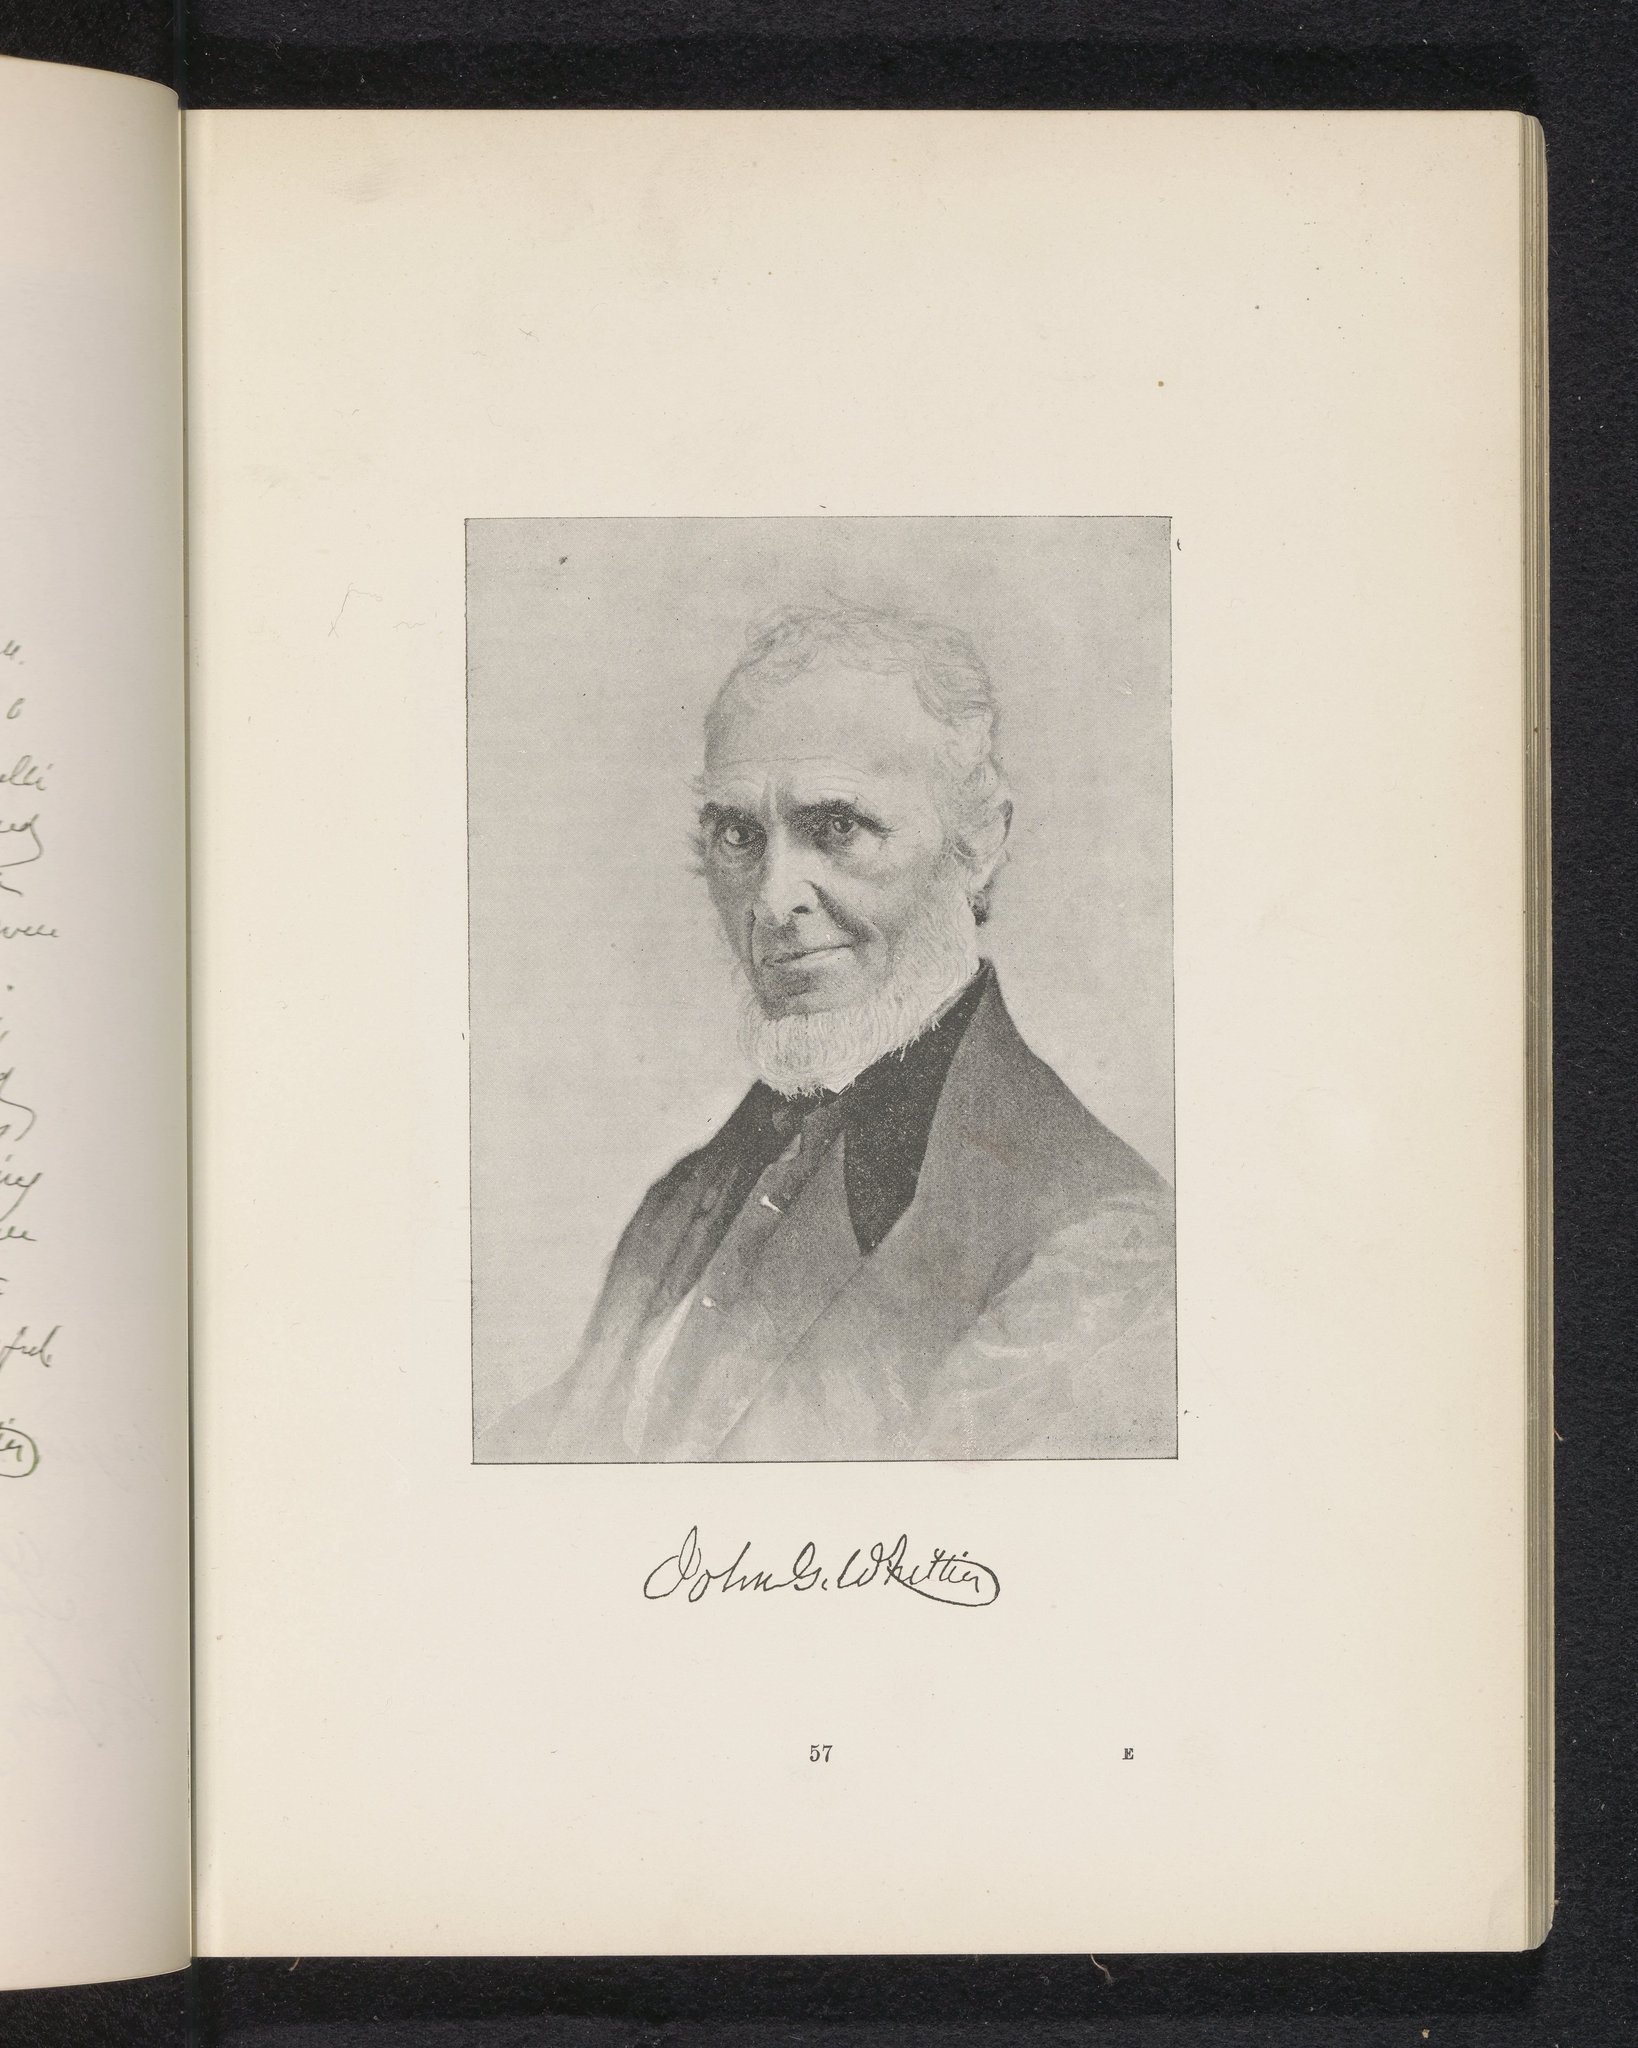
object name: photomechanical print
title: Portret van John Greenleaf Whittier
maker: Anonymous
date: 1881-1891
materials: paper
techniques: autotype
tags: john greenleaf whittier, portrait of a writer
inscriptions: inscription